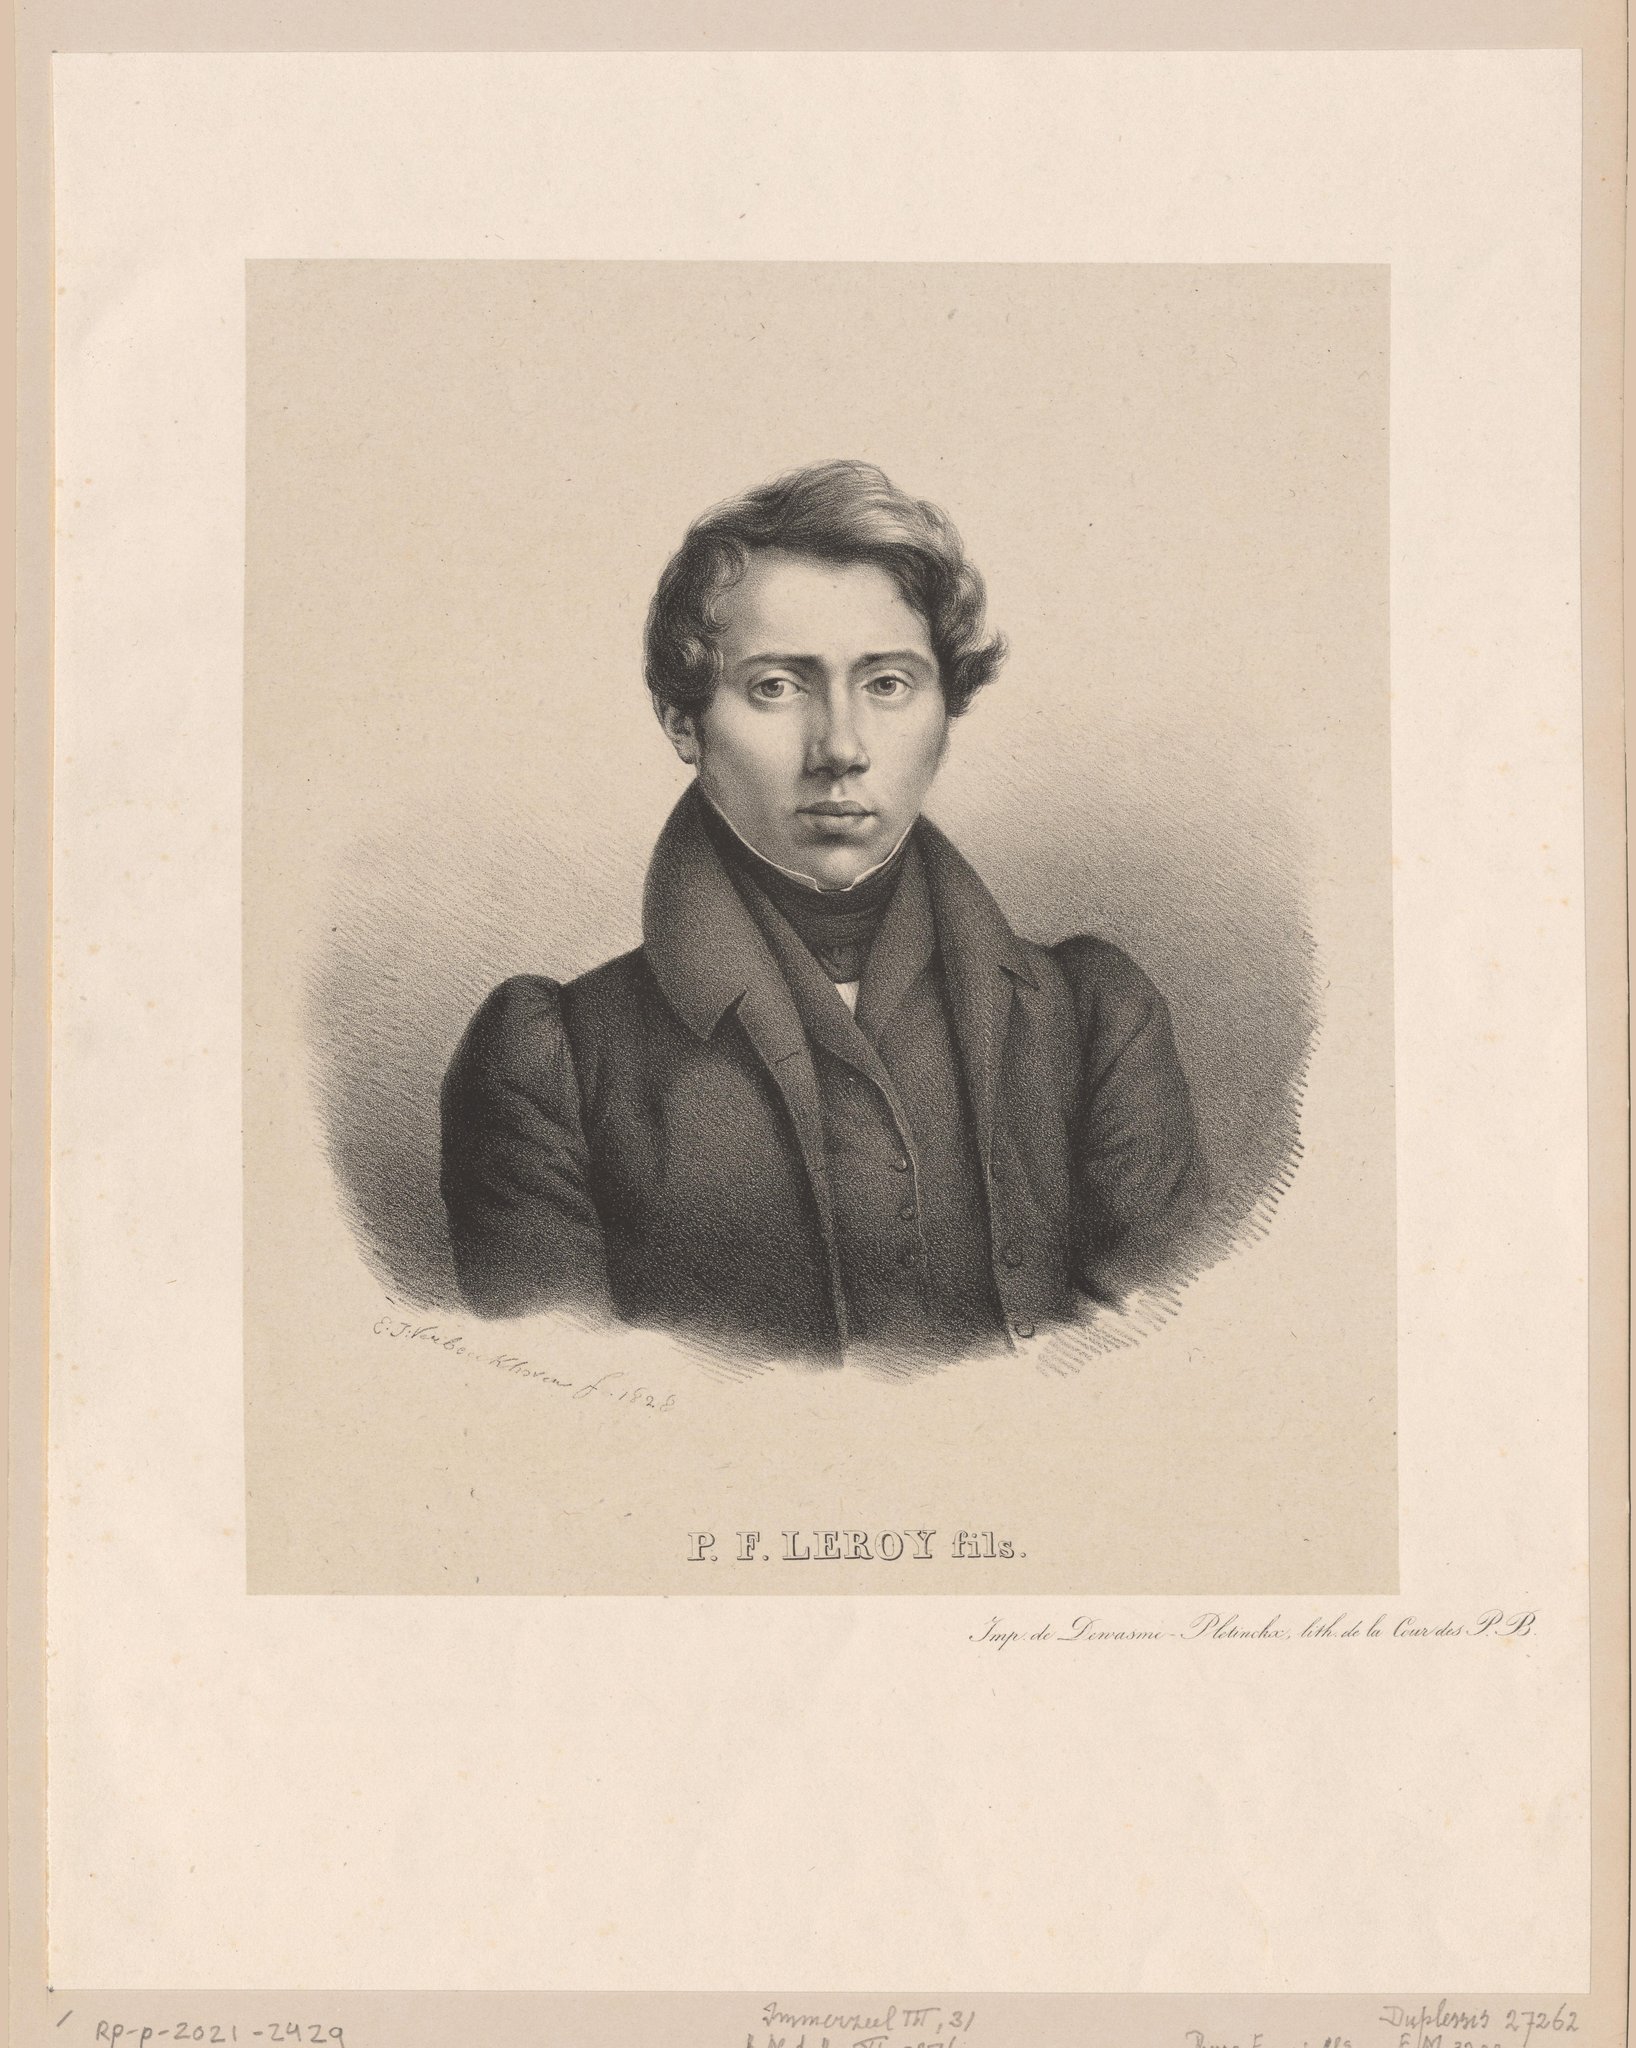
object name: print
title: Portret van Pierre François Charles Leroy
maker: lith. de la cour des ps. bas à bruxelles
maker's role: printer, publisher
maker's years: 1797-1851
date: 1828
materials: paper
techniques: lithograph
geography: brussels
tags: painter, draughtsman, pierre françois charles leroy, historical persons, portrait, self-portrait of painter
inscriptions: date